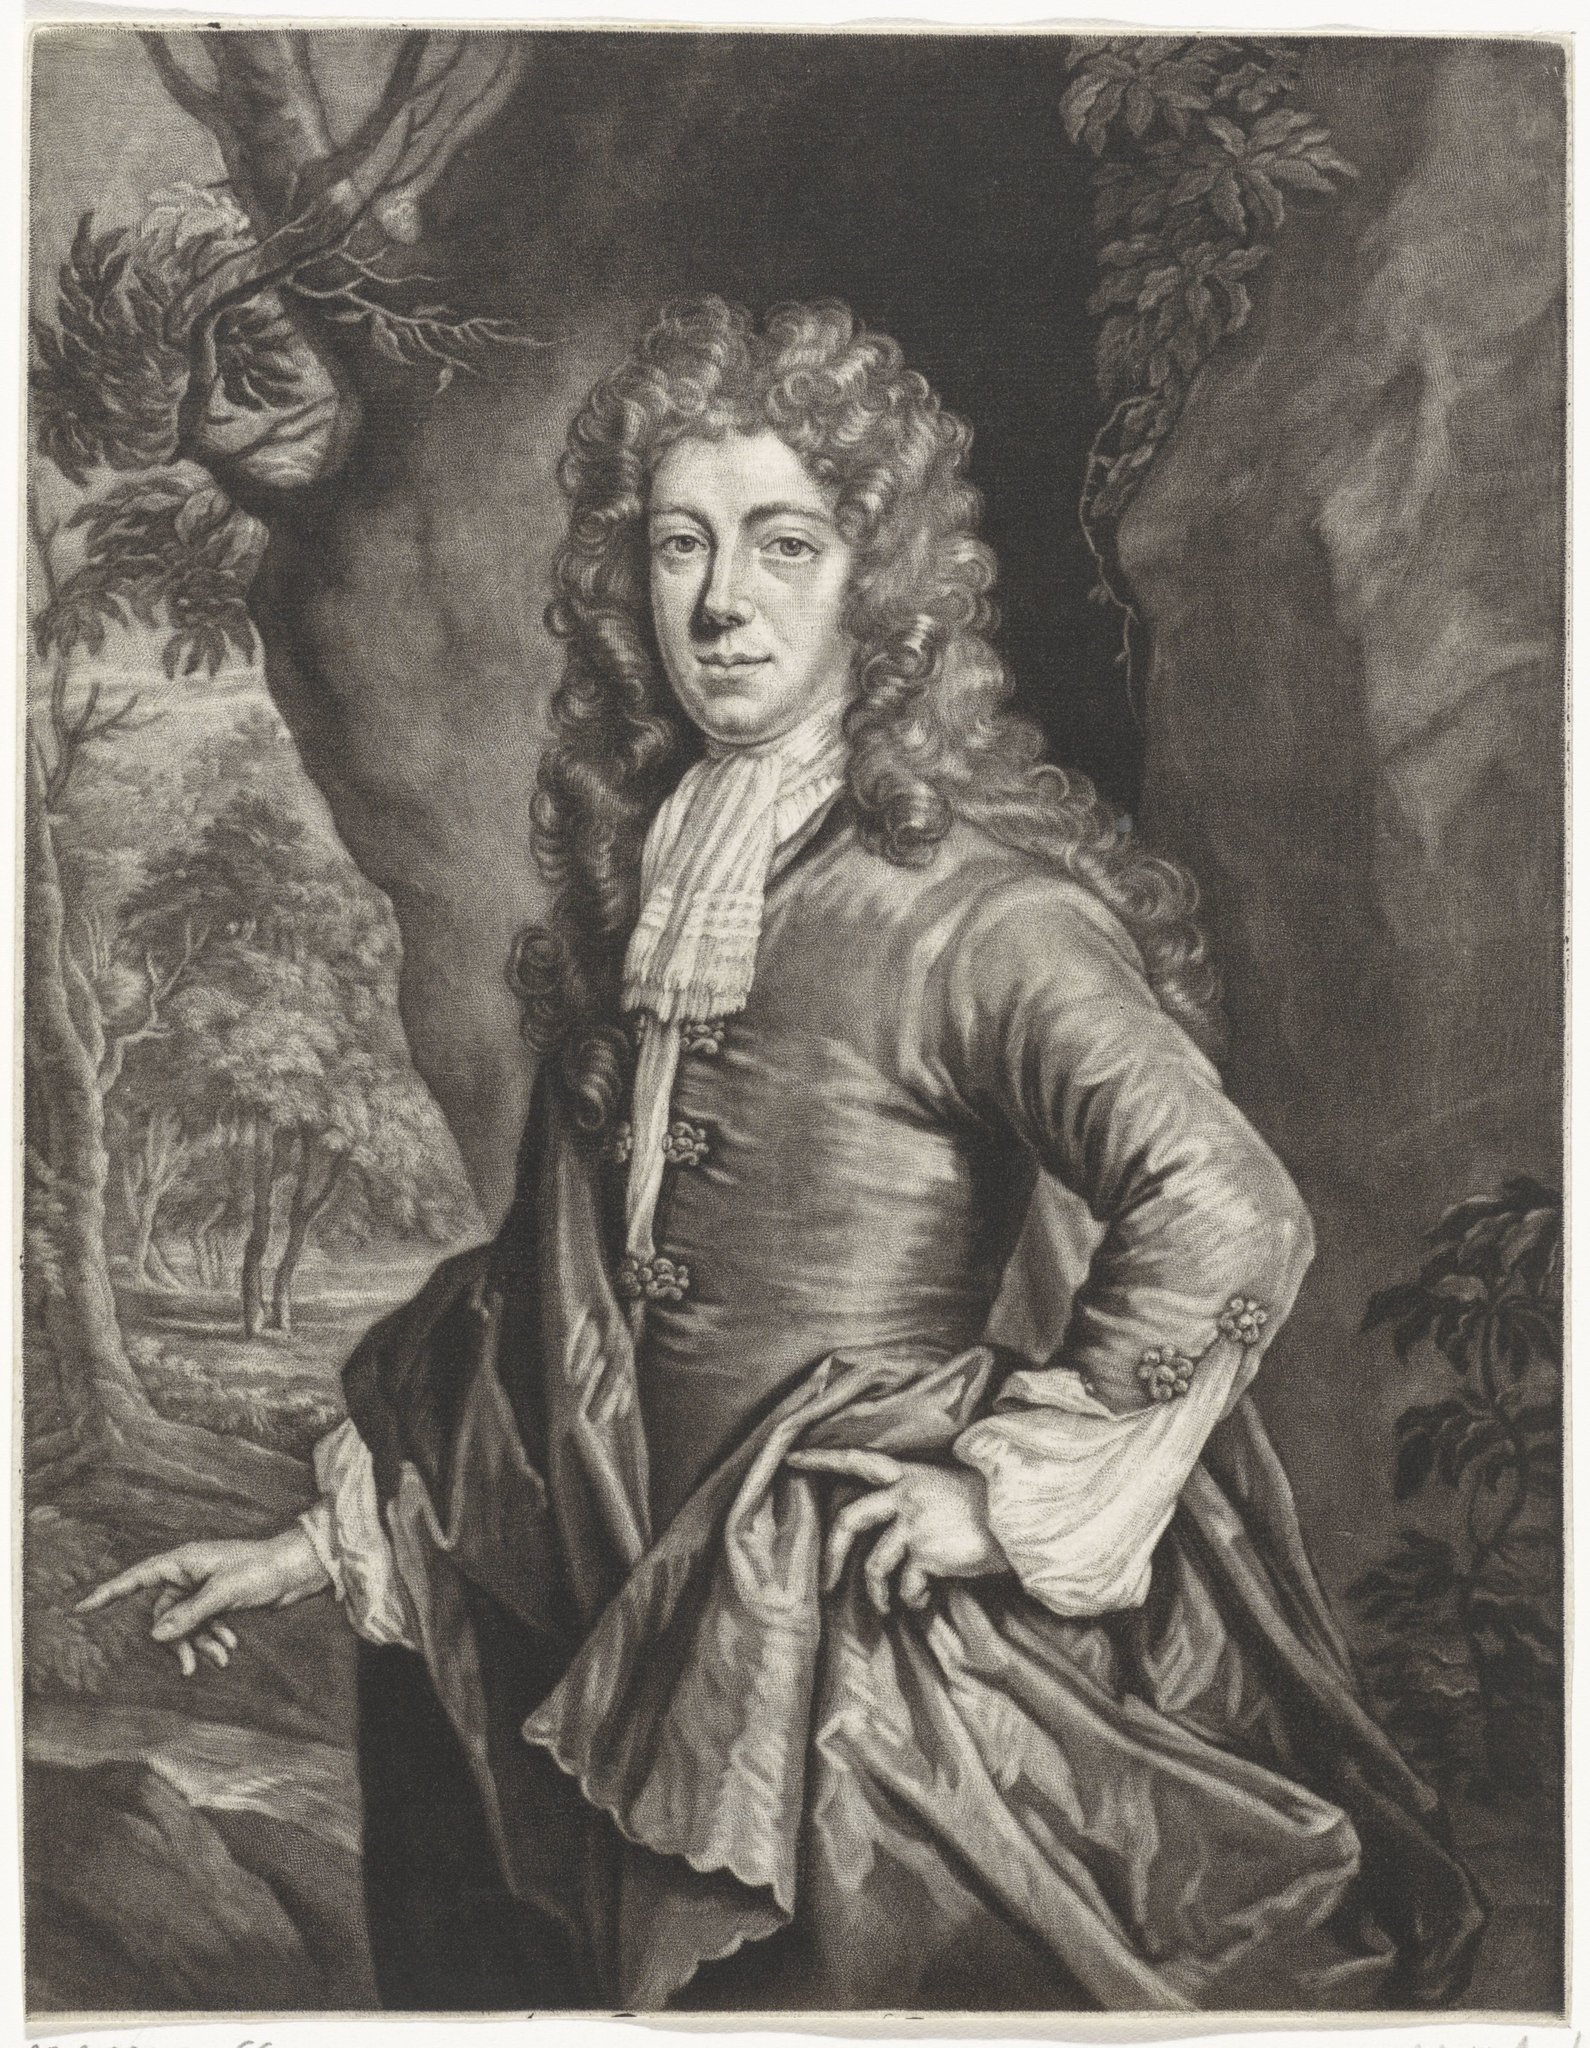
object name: print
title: Portret van Hendrik Casimir II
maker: jacob gole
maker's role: print maker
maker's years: 1660-1724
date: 1670-1724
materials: paper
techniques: mezzotint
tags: the hague, hendrik casimir ii graaf van nassau-dietz, forest, wood, wig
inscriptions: collector's mark: Lugt 2228, collector's mark: Lugt 567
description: Portret van Hendrik Casimir II, graaf van Nassau-Dietz en stadhouder van Friesland, Groningen en Drente.